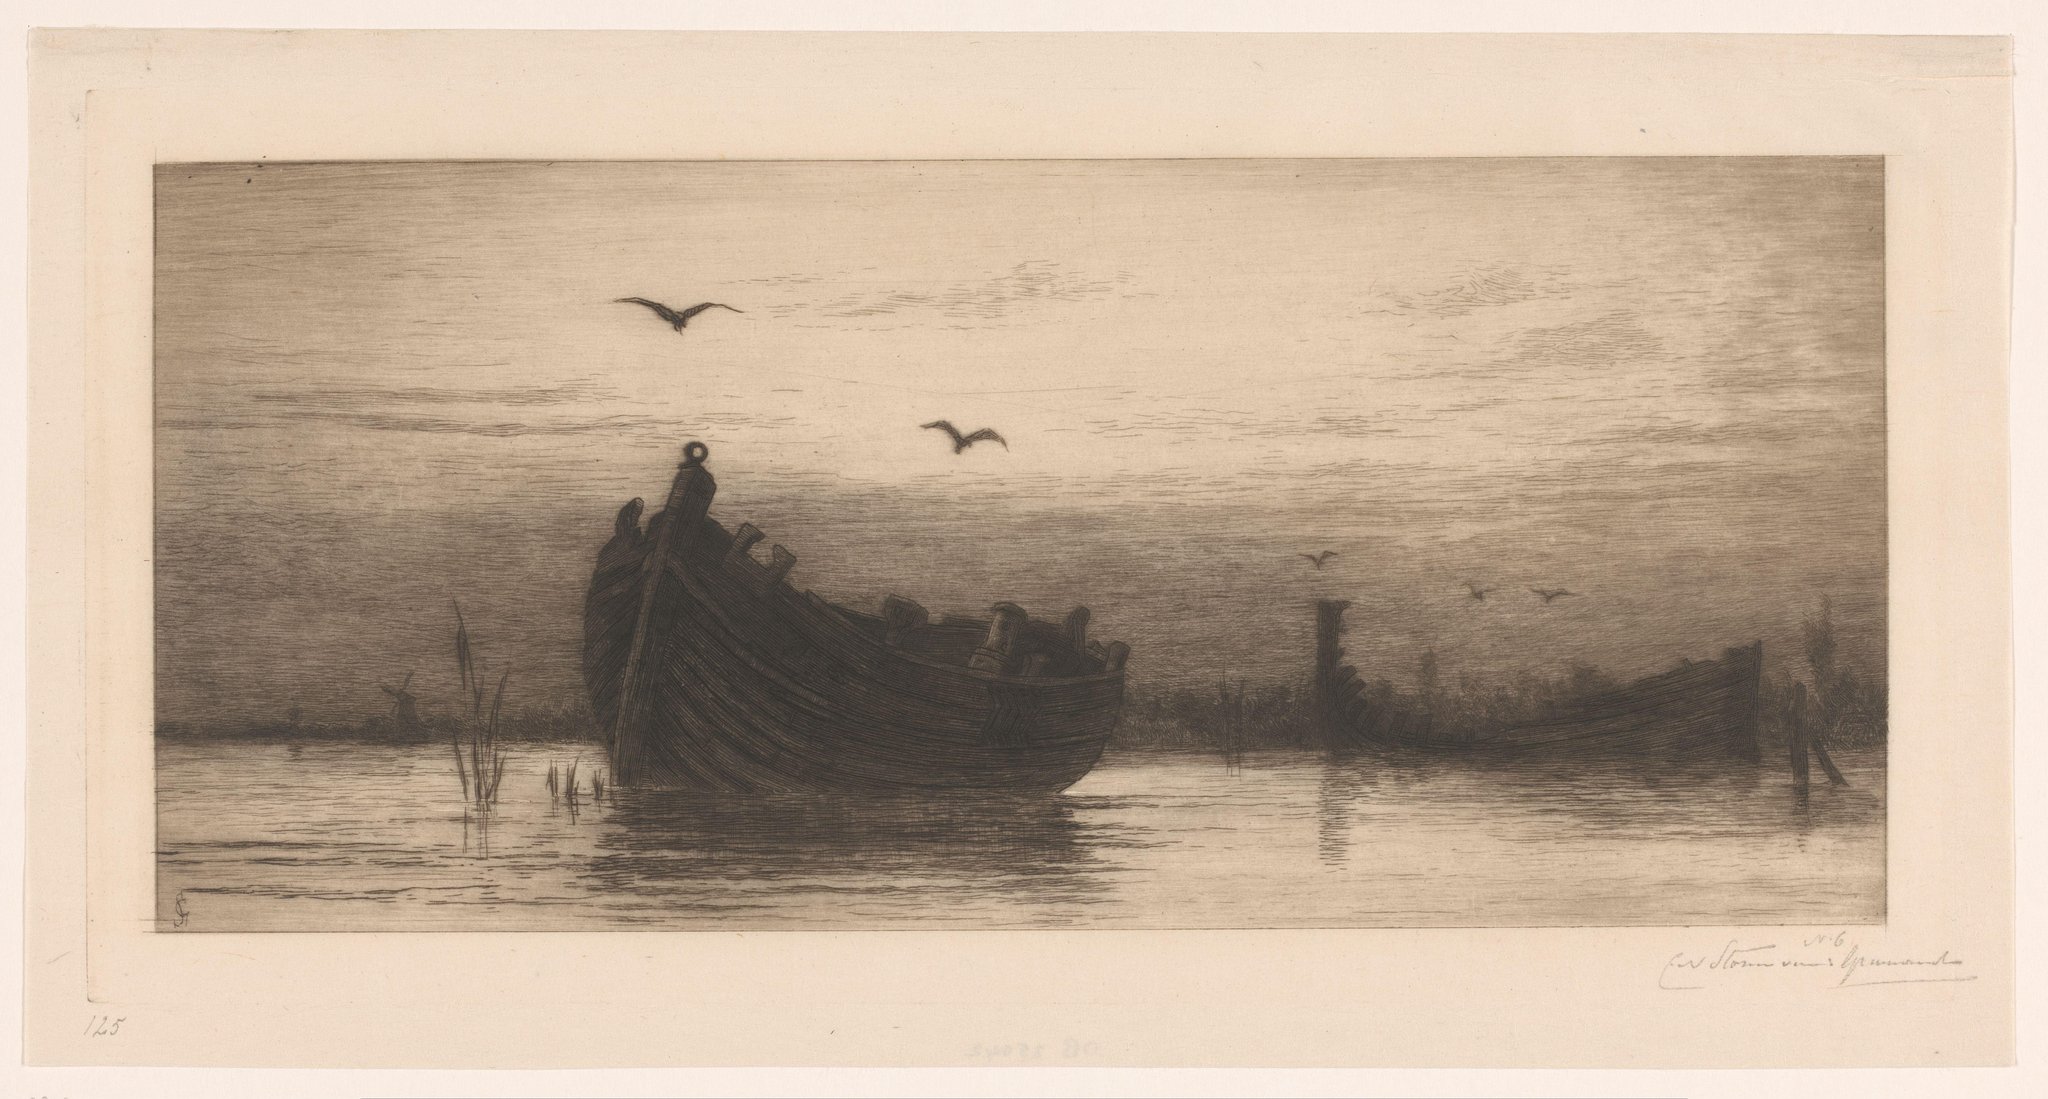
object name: print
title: Epaves dans le biesbosch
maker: carel nicolaas storm van s-gravesande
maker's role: draughtsman, print maker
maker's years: 1841-1924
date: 1880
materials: paper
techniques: drypoint, etching, intaglio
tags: shipwreck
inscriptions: collector's mark: Lugt 2228, number: ‘N. 6’